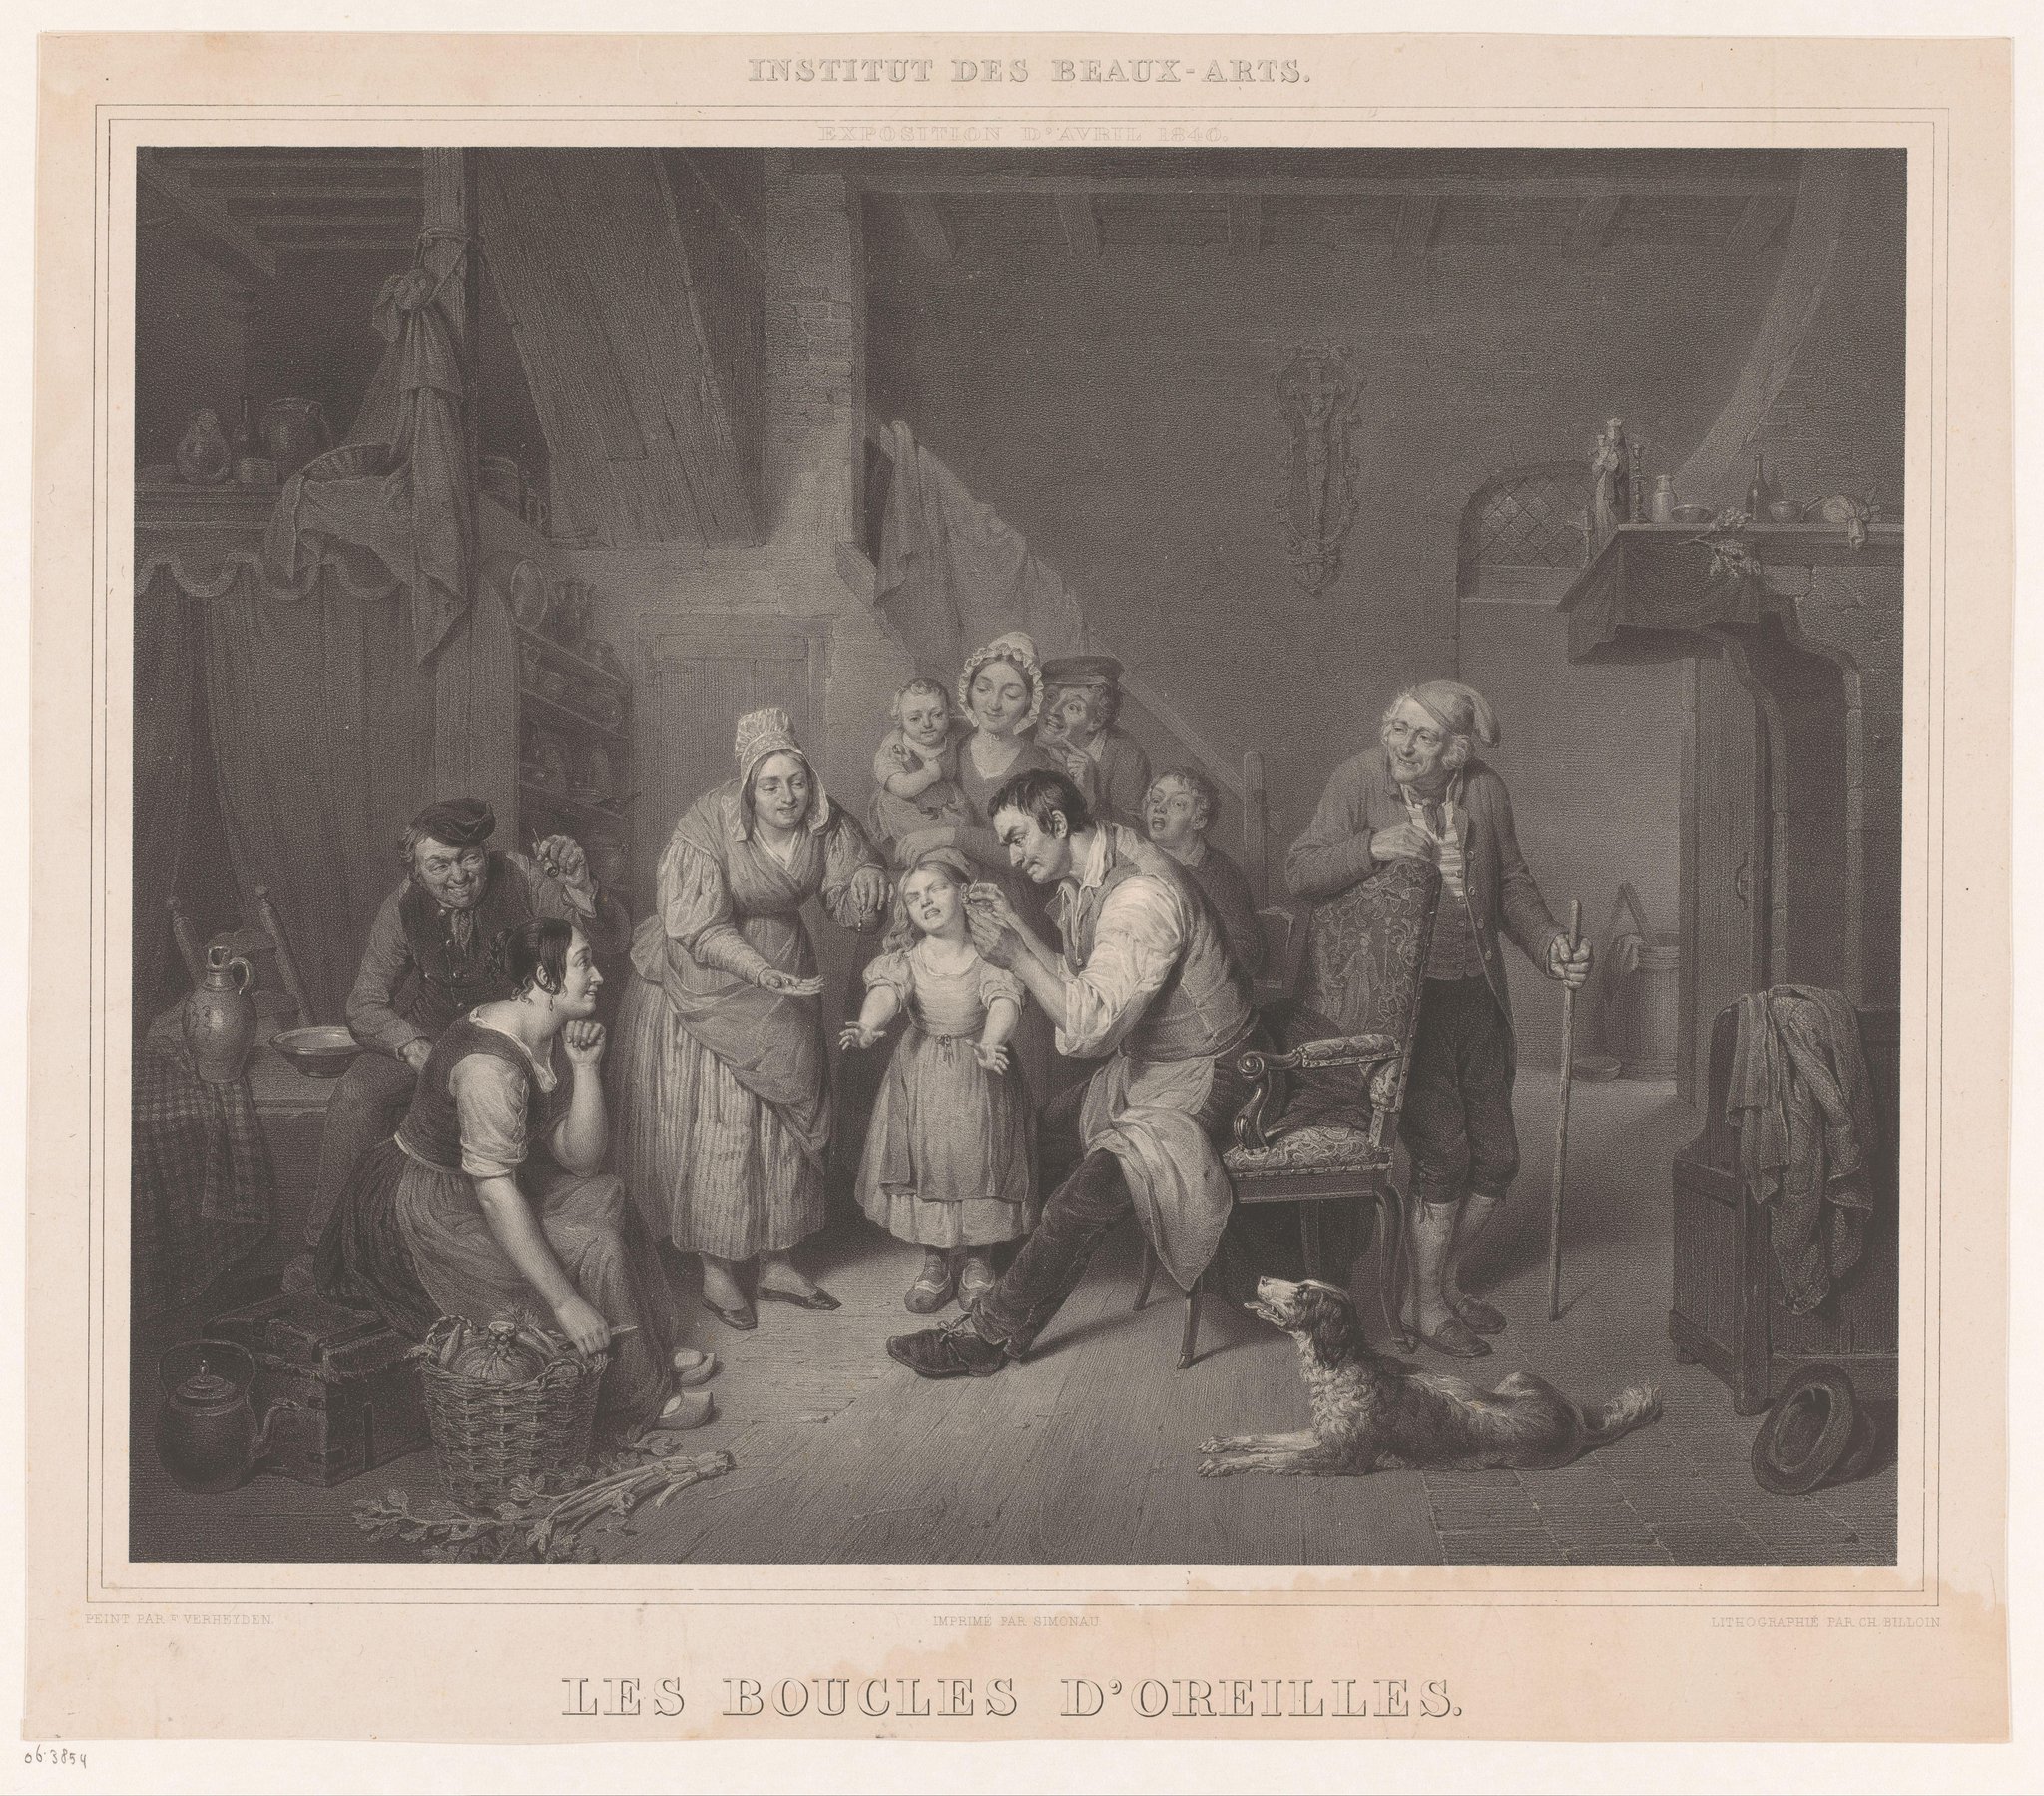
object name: print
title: Les boucles d'oreilles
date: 1840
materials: paper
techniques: lithograph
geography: brussels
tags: interior of the house, family life at home, child (at home) - aa - girl, ear-rings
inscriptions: collector's mark: Lugt 2228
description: Prent behoort mogelijk tot een serie prenten met tentoongestelde kunstwerken van de Institut des Beaux-Arts.